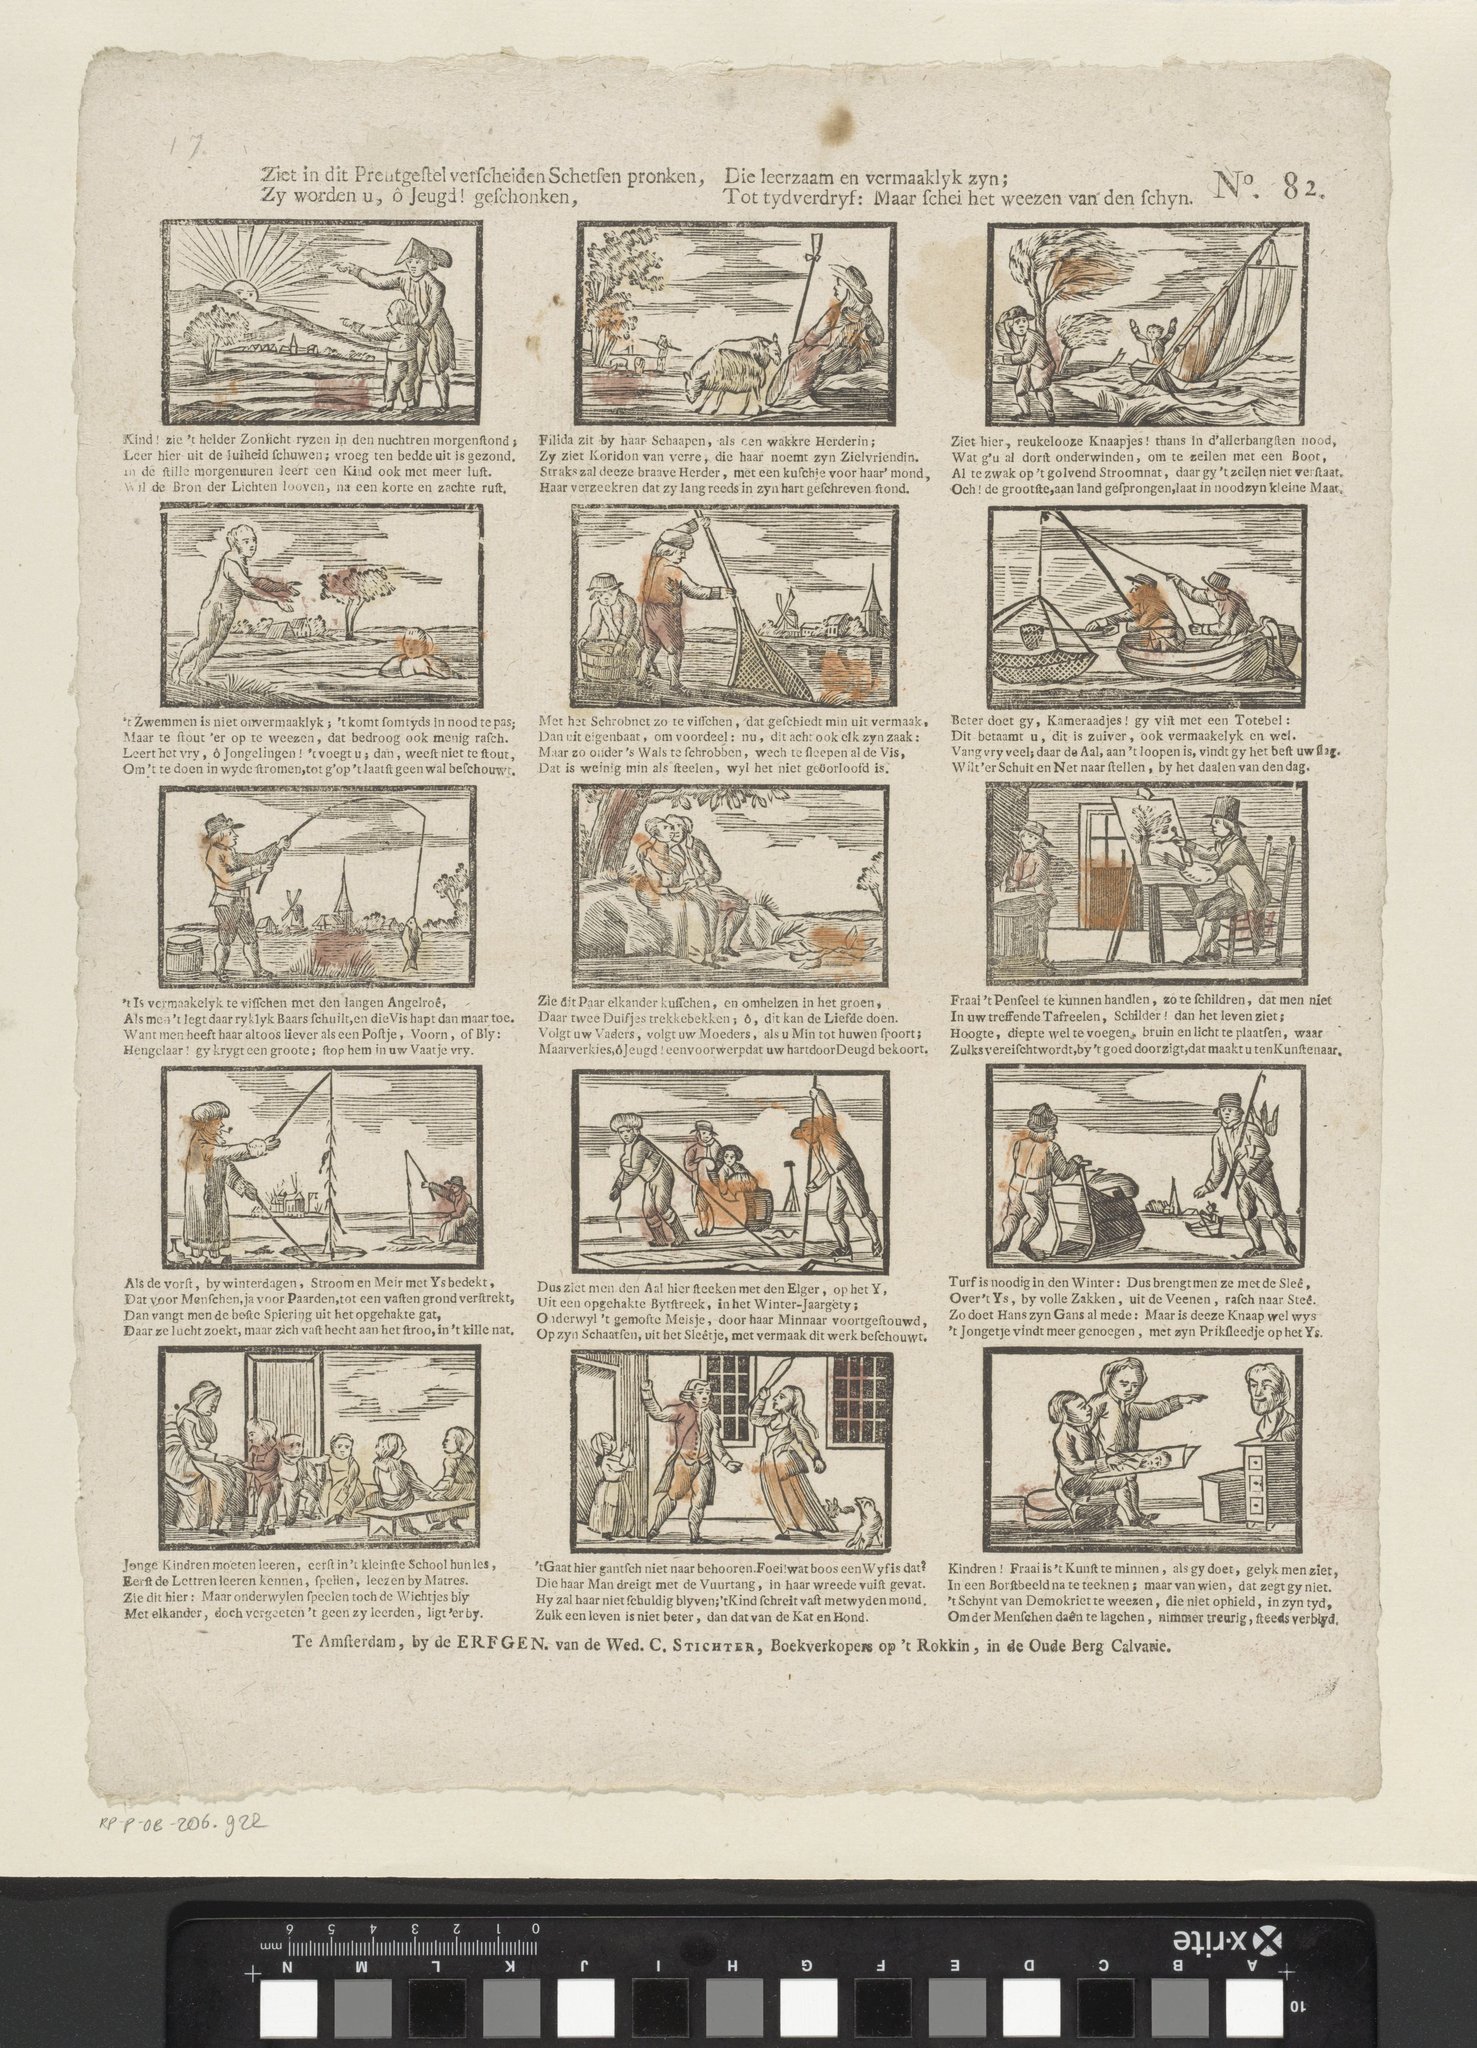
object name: popular print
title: Ziet in dit prentgestel verscheiden schetsen pronken, / Zy worden u, ô jeugd! geschonken, / Die leerzaam en vermaaklyk zyn; / Tot tydverdryf: Maar schei het weezen van den schyn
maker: Anonymous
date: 1715-1813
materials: paper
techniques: colour, letterpress printing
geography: netherlands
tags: herding, herdsman, herdswoman, shepherd, shepherdess, cowherd, etc., drawing-lesson, fisherman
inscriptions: collector's mark: Lugt 2760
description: Blad met 15 voorstellingen van beroepen en bezigheden, zoals zeilen, vissen en tekenen. Onder elke afbeelding een vierregelig vers. Genummerd rechtsboven: No. 82.